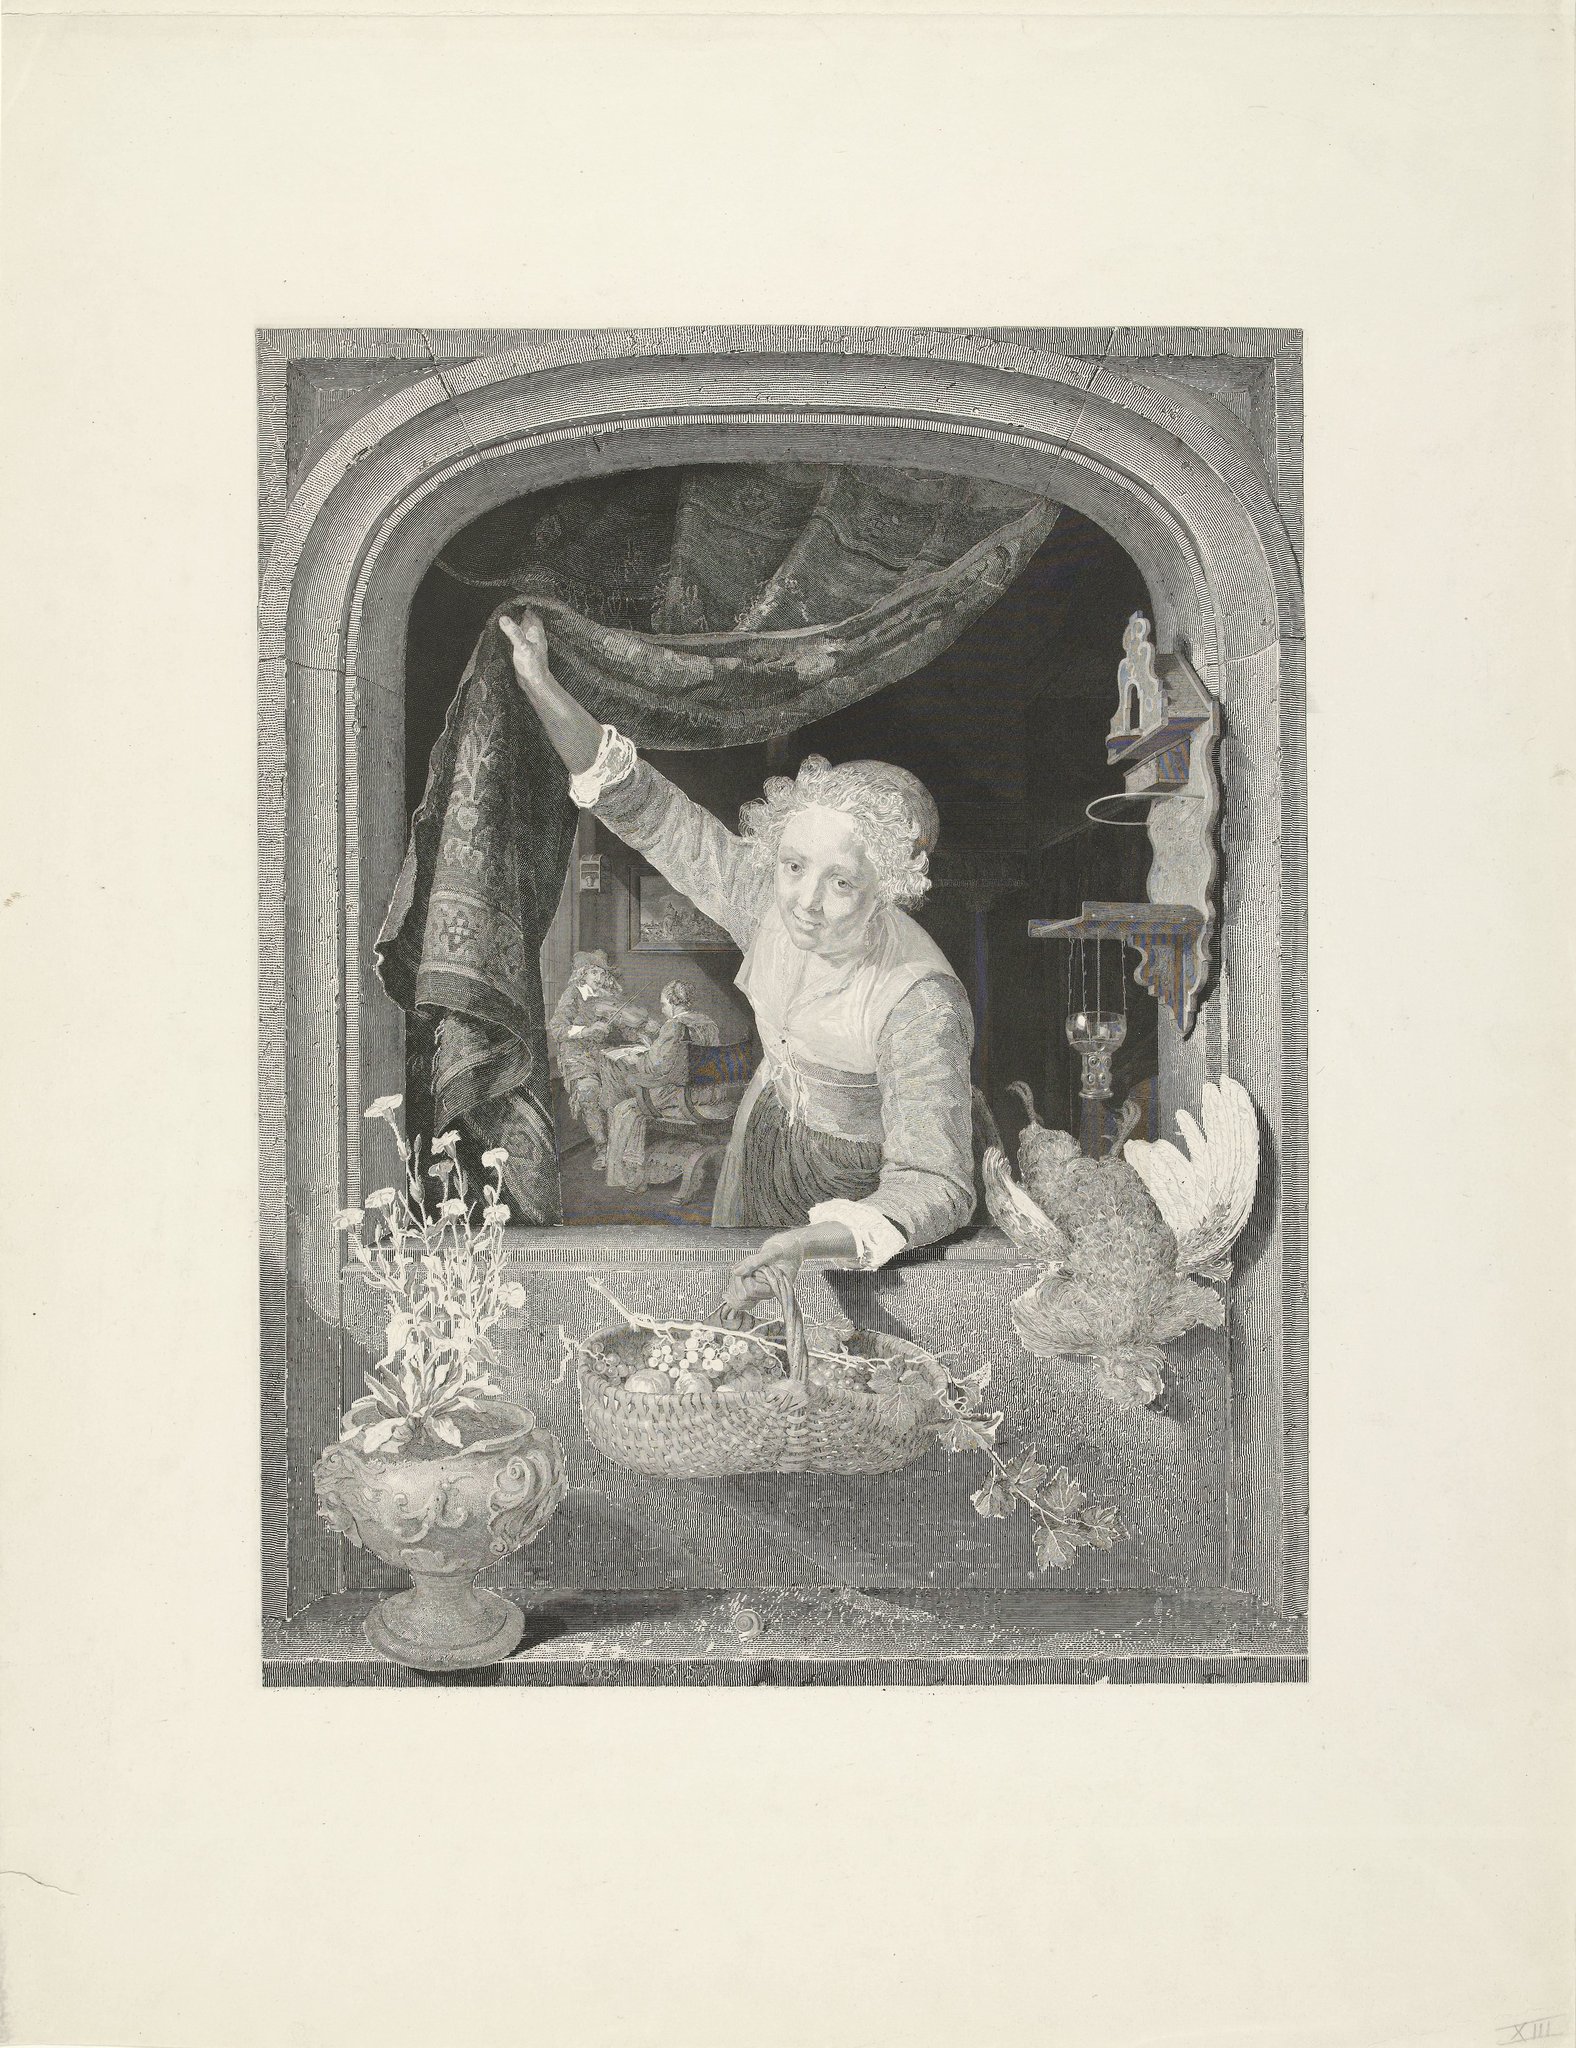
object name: print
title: Vrouw met mand met vruchten in de hand bij het raam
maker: henricus wilhelmus couwenberg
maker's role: draughtsman, print maker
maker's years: 1814-1845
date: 1842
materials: paper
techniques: etching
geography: amsterdam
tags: instrumental and vocal music together, human figure at (open) window, seen from outside, shop-window, show-window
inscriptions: collector's mark: Lugt 2228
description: Een jonge vrouw met een mand met vruchten in de hand hangt uit een venster. Ze houdt het gordijn opzij zodat het interieur achter haar zichtbaar is. In het vertrek zijn een man en een vrouw aan het musiceren. In de vensterbank hangt een vogelhuis, ligt een dode haan en staat een vaas met bloemen.